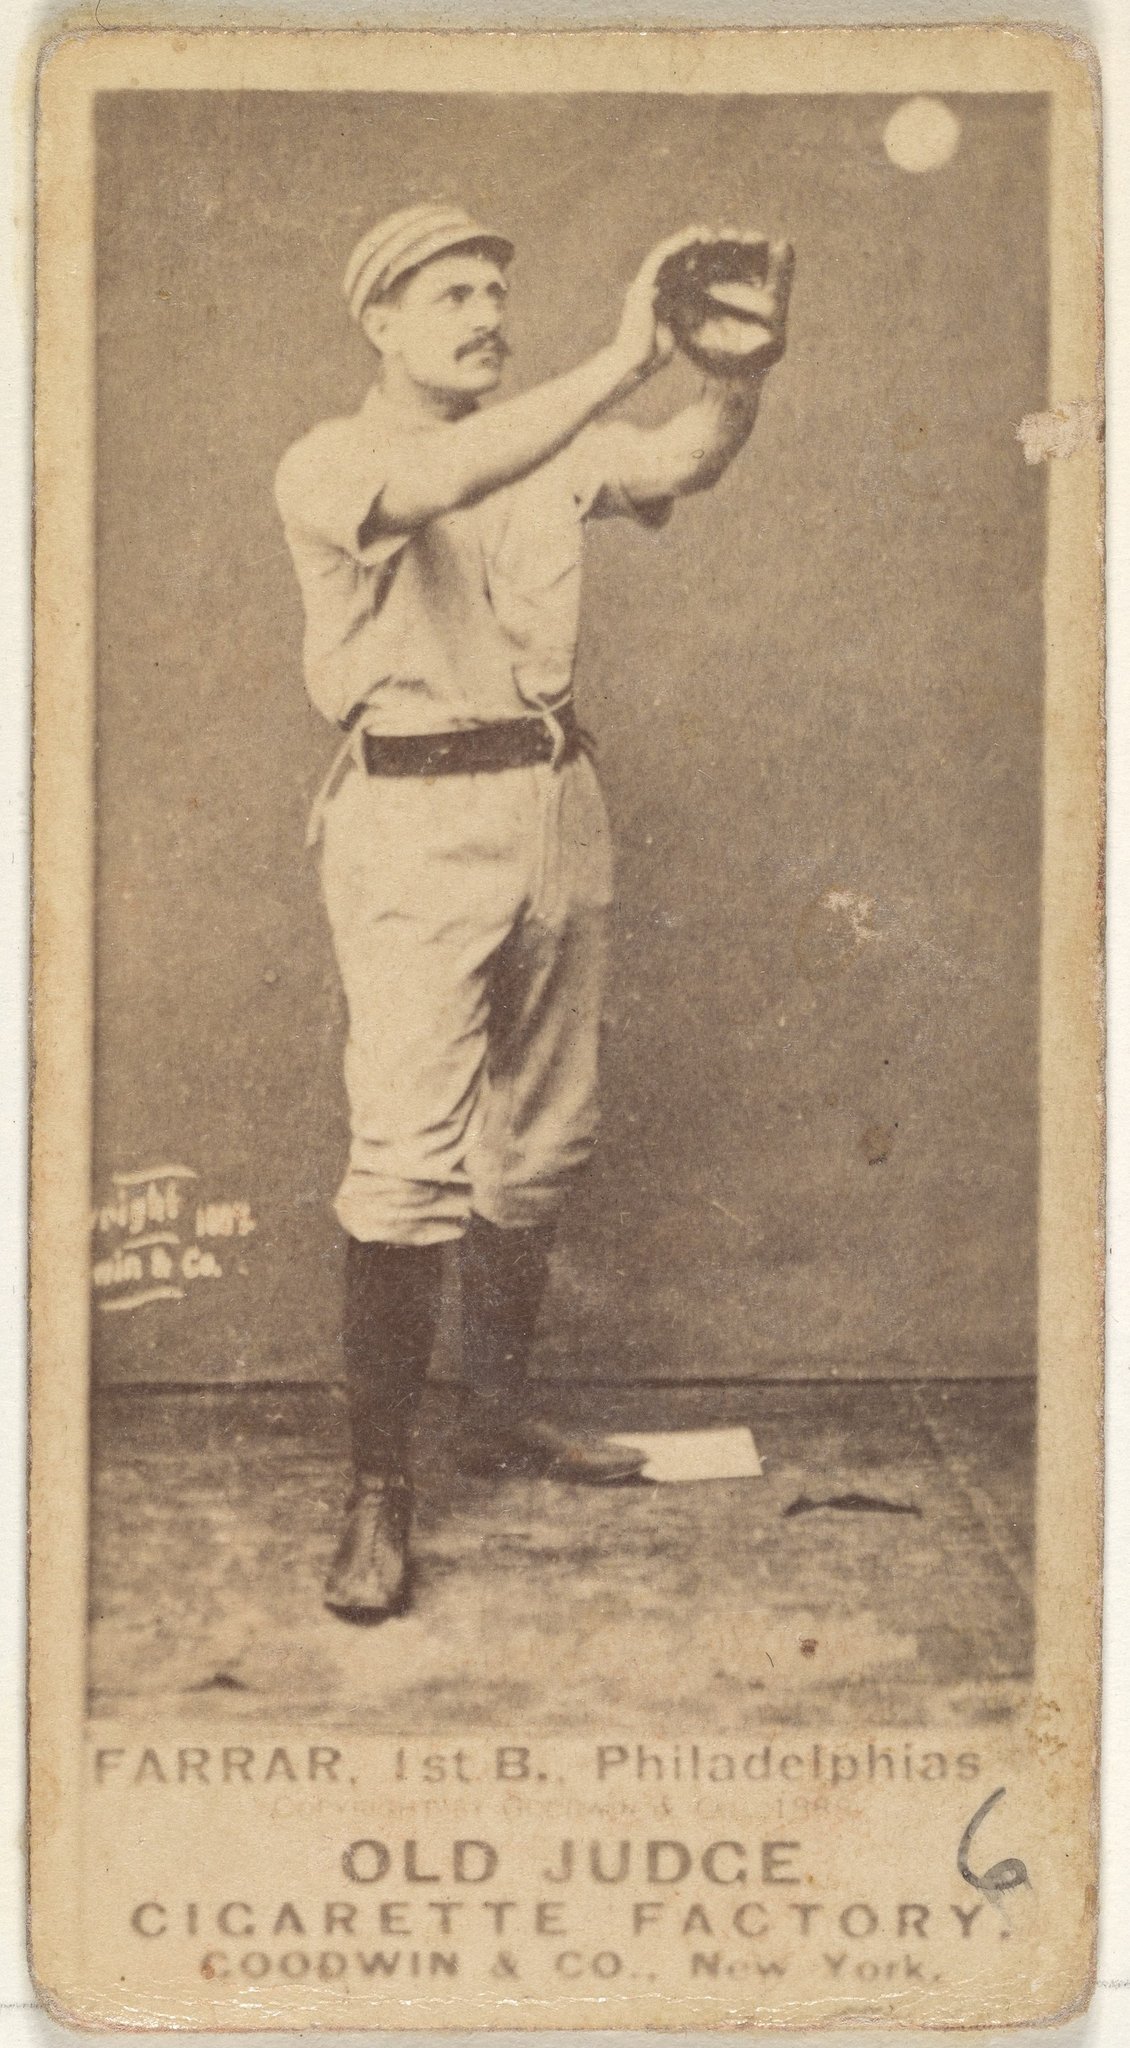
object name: baseball card, photograph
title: Sidney Douglas Farrar, 1st Base, Philadelphia, from the Old Judge series (N172) for Old Judge Cigarettes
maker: goodwin & company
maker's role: publisher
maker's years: 1850-1950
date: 1887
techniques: albumen silver print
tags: men,portraits,baseball,athletes